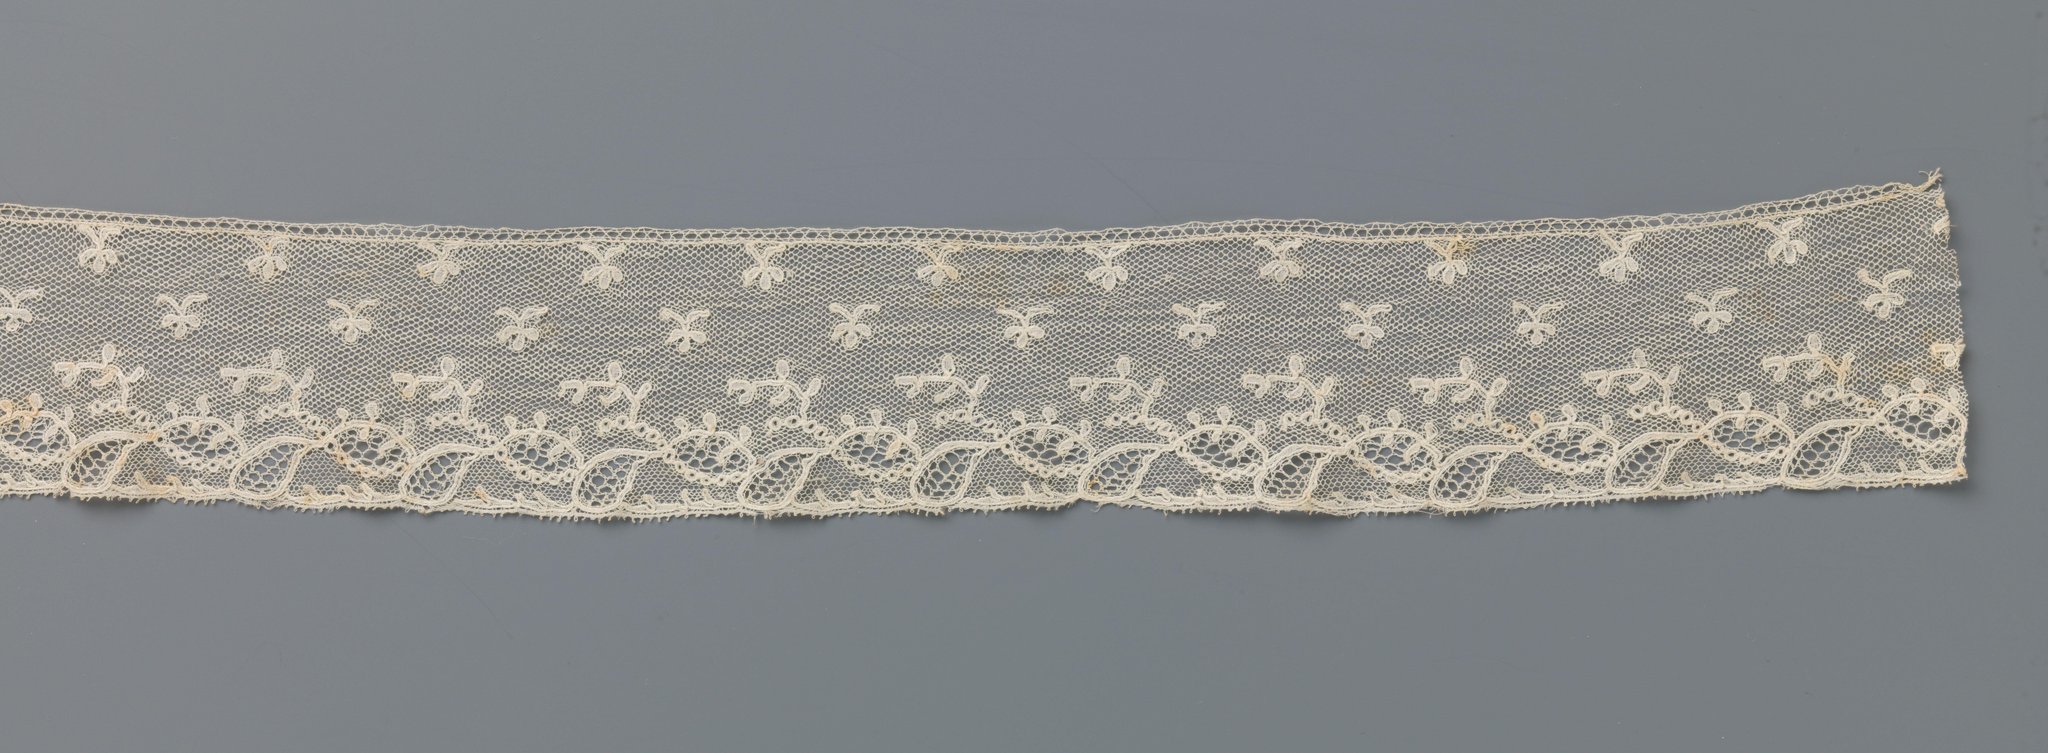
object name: strip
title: Strook kloskant met gekantelde ovaaltjes onder strooipatroon van takjes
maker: Anonymous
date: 1785-1799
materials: linen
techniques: lace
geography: mechelen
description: Strook naturelkleurige kloskant: Mechelse kant. Het zich herhalende en doorlopende patroon bestaat langs de onderrand uit een aaneenschakeling van spitsovaaltjes en druppelvormen, die ten opzichte van elkaar steeds iets gekanteld zijn. Onder het ovaaltje loopt een kort slingertje van cirkeltjes door, waaruit boven de druppelvorm een bladertakje ontspringt. Boven dit patroon staat een strooipatroon van twee rijen losse takjes. De motieven zijn met elkaar verbonden door een fijne maasgrond, de Mechelse grond. Het spaarzame volwerk is gemaakt in linnenslag, dat door de dikkere en glimmende contourdraden hier en daar bijna verdwijnt. Twee verschillende maar sterk gelijkende siergronden, met grove mazen, zijn toegepast in de ovalen en druppelvormen. De rechte onderzijde is afgewerkt met picots. De bovenzijde is afgewerkt met een apart geklost bandje.